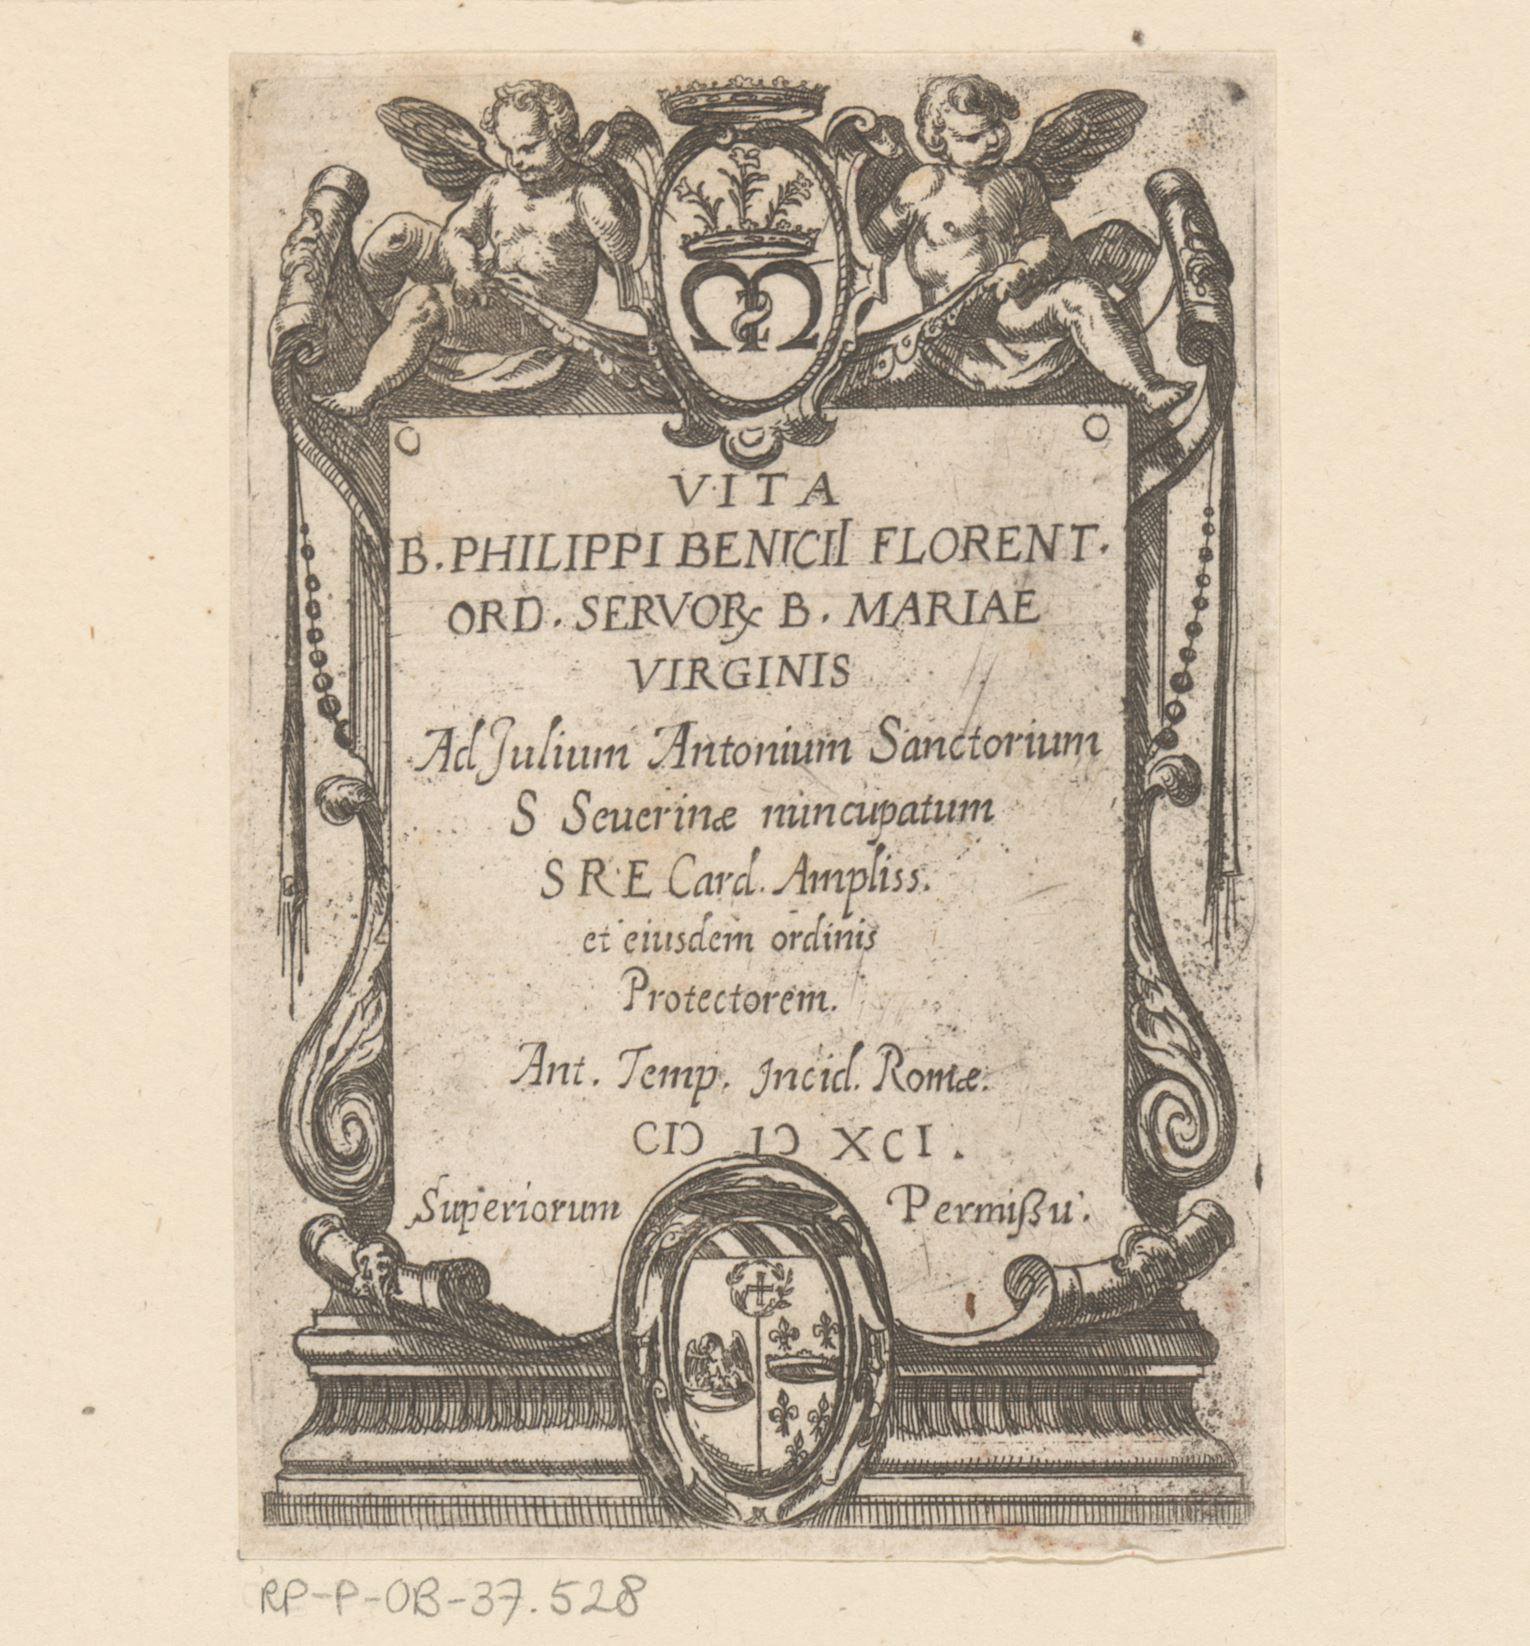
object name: print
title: Het Leven van Philippus Benitius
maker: antonio tempesta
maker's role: draughtsman, painter, print maker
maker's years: 1555-1630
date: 1591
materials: paper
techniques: etching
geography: rome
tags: clergyman, ornament ~ cartouche, ruler, sovereign, cupids: 'amores', 'amoretti', 'putti'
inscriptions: collector's mark: Lugt 240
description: Titelprent bij een serie van zestien prenten over het leven van Philippus Benitius.